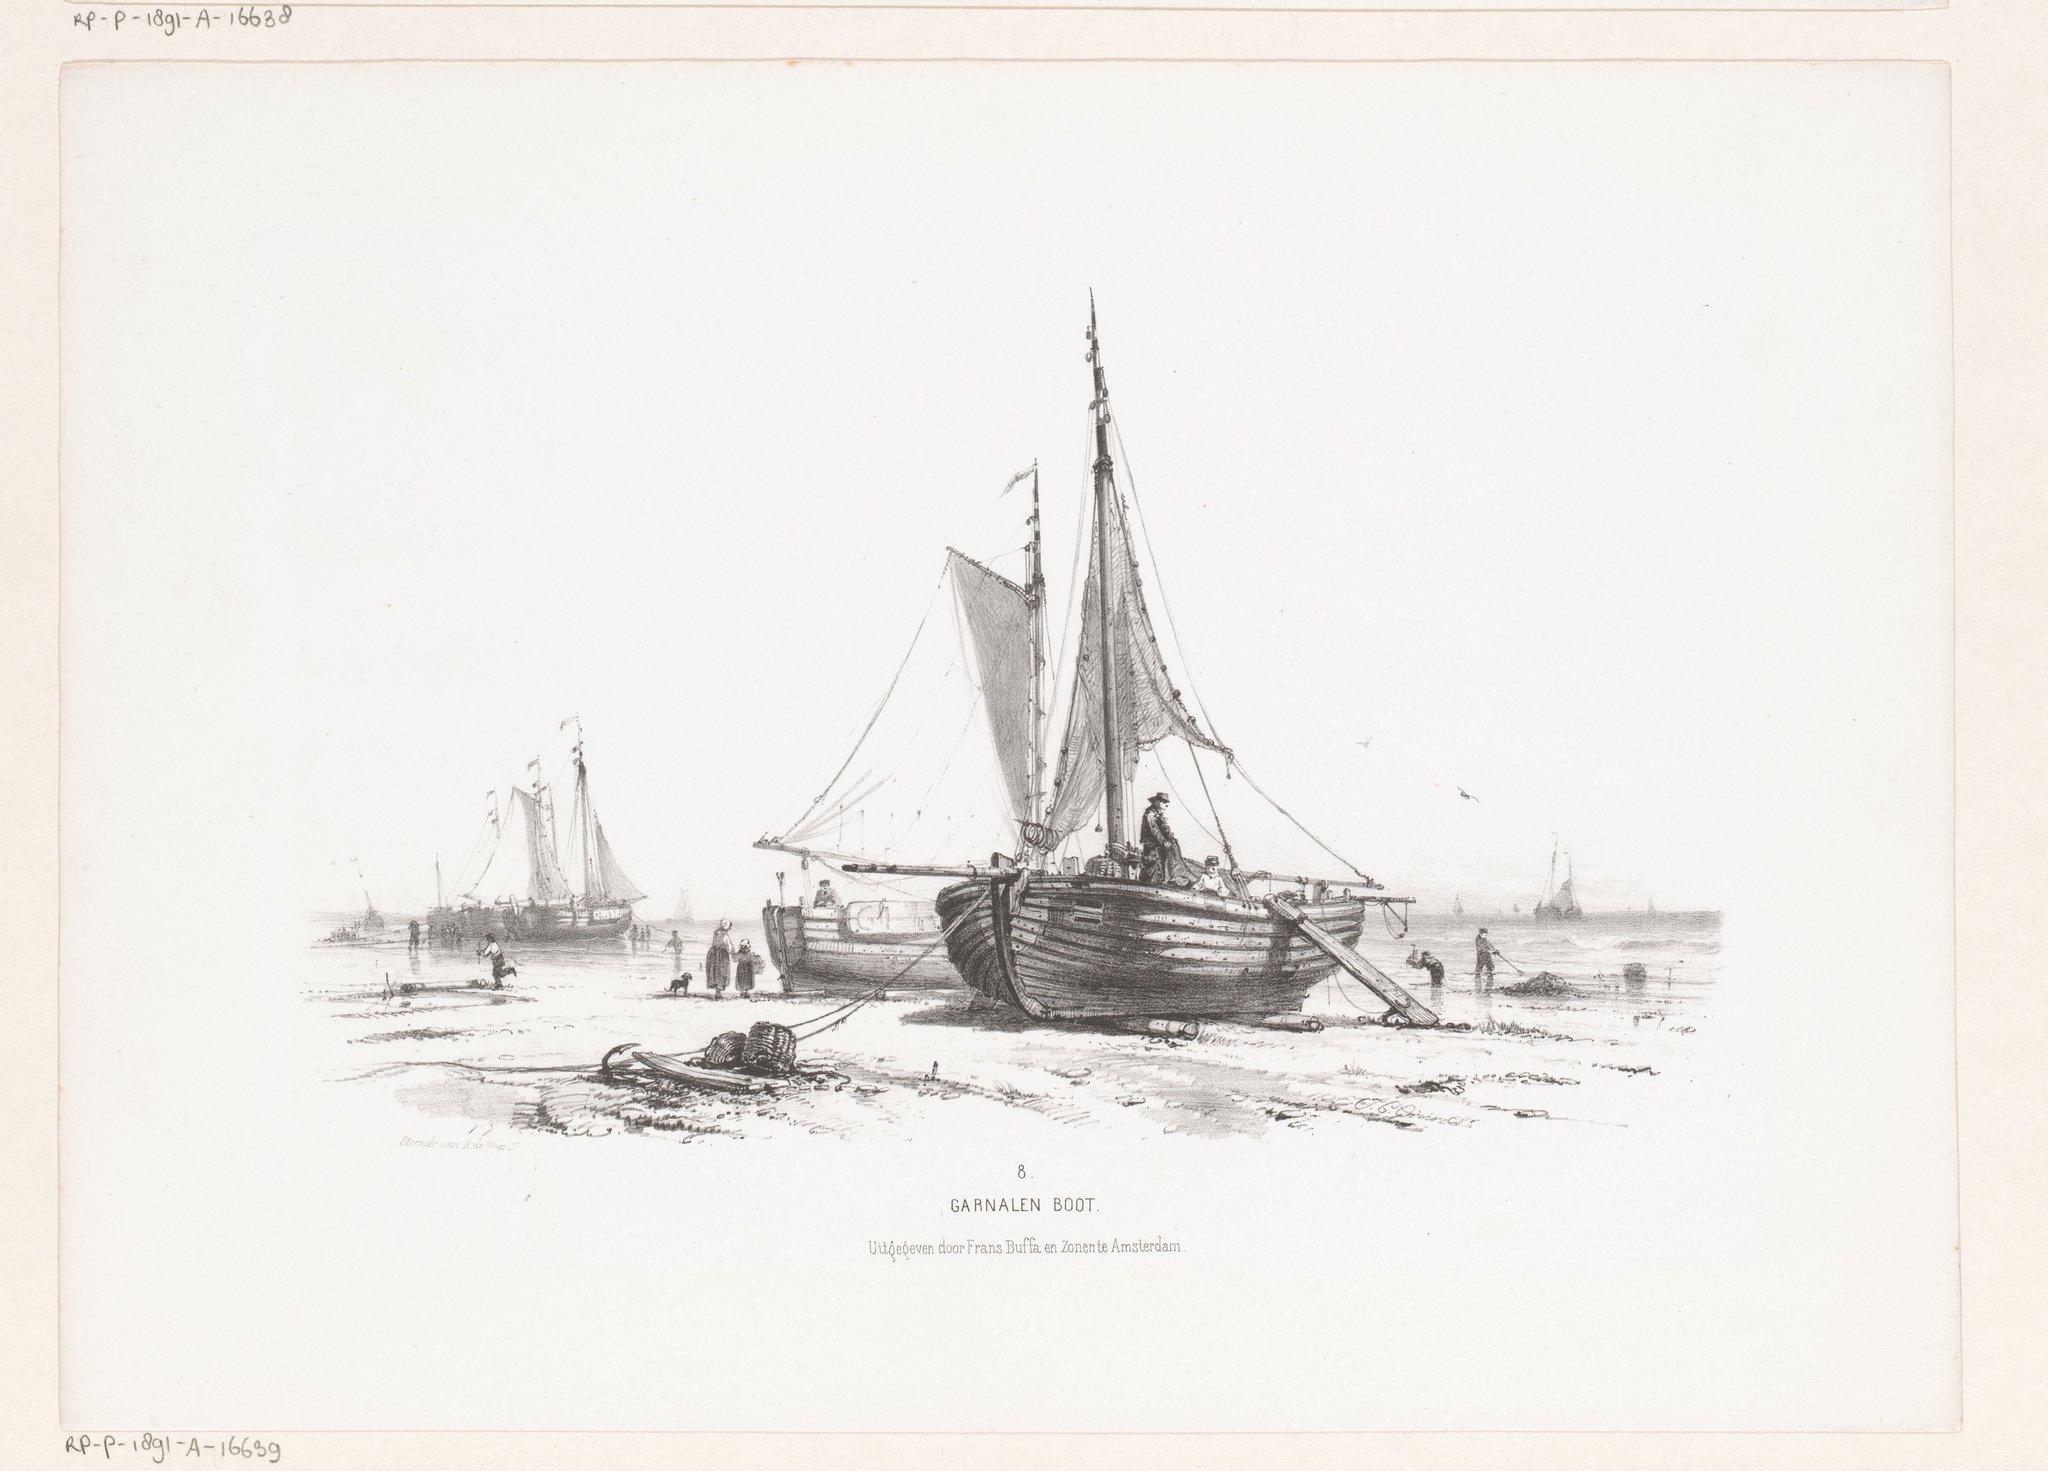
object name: print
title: Garnalen boot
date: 1860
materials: paper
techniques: lithograph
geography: netherlands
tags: sailing-ship, sailing-boat, ships, boats on land, beached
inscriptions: collector's mark: Lugt 2228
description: De boot ligt op het strand. Op het dek staan twee figuren.